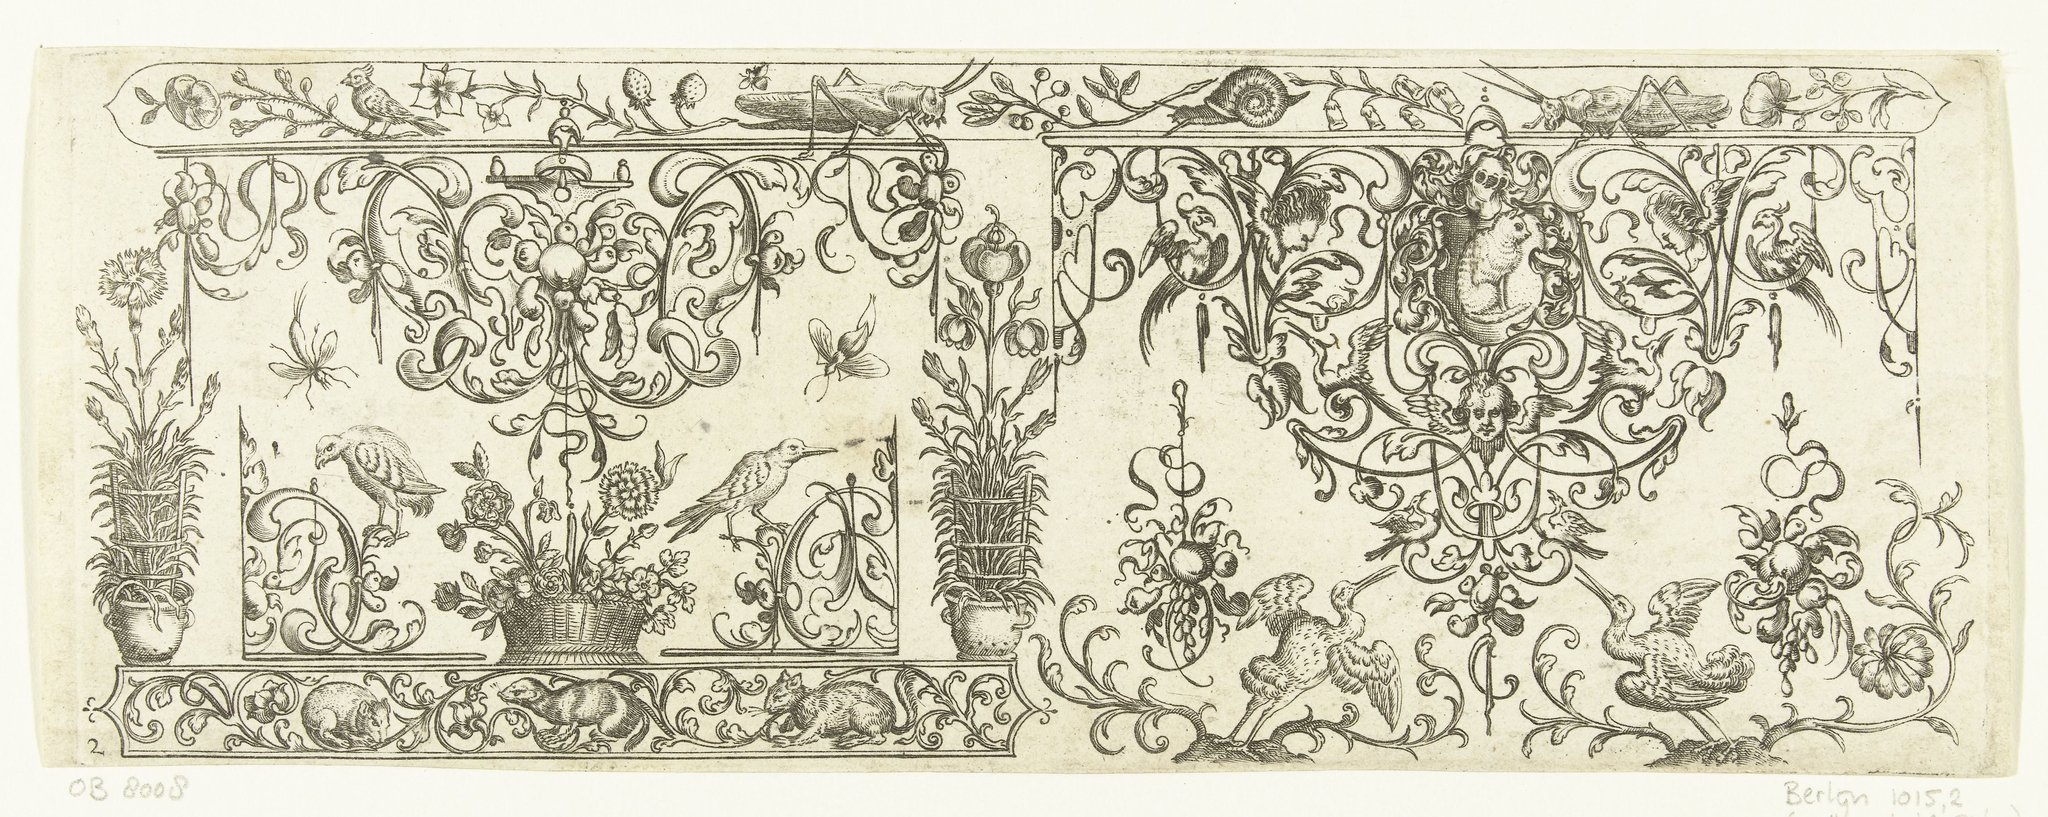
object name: print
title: Spitsen en randen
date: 1611-1656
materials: paper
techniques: engraving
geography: france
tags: flowers, fantasy ornament, cat, birds, container made of plant material other than wood: basket, insects: cricket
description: Tegenzijdige kopie naar prenten (blad 10 en 4) uit de serie Somige Eenvoldige Vruchten en Spitsen. Links staat midden onder een mand met bloemen tussen twee vogels, rechtsboven is een kat afgebeeld. Uit serie bladen waarop telkens twee motieven naast elkaar te zien zijn, aangevuld met vogels, insecten, bloempotten en soms een ornamentele rand met ranken en dieren.